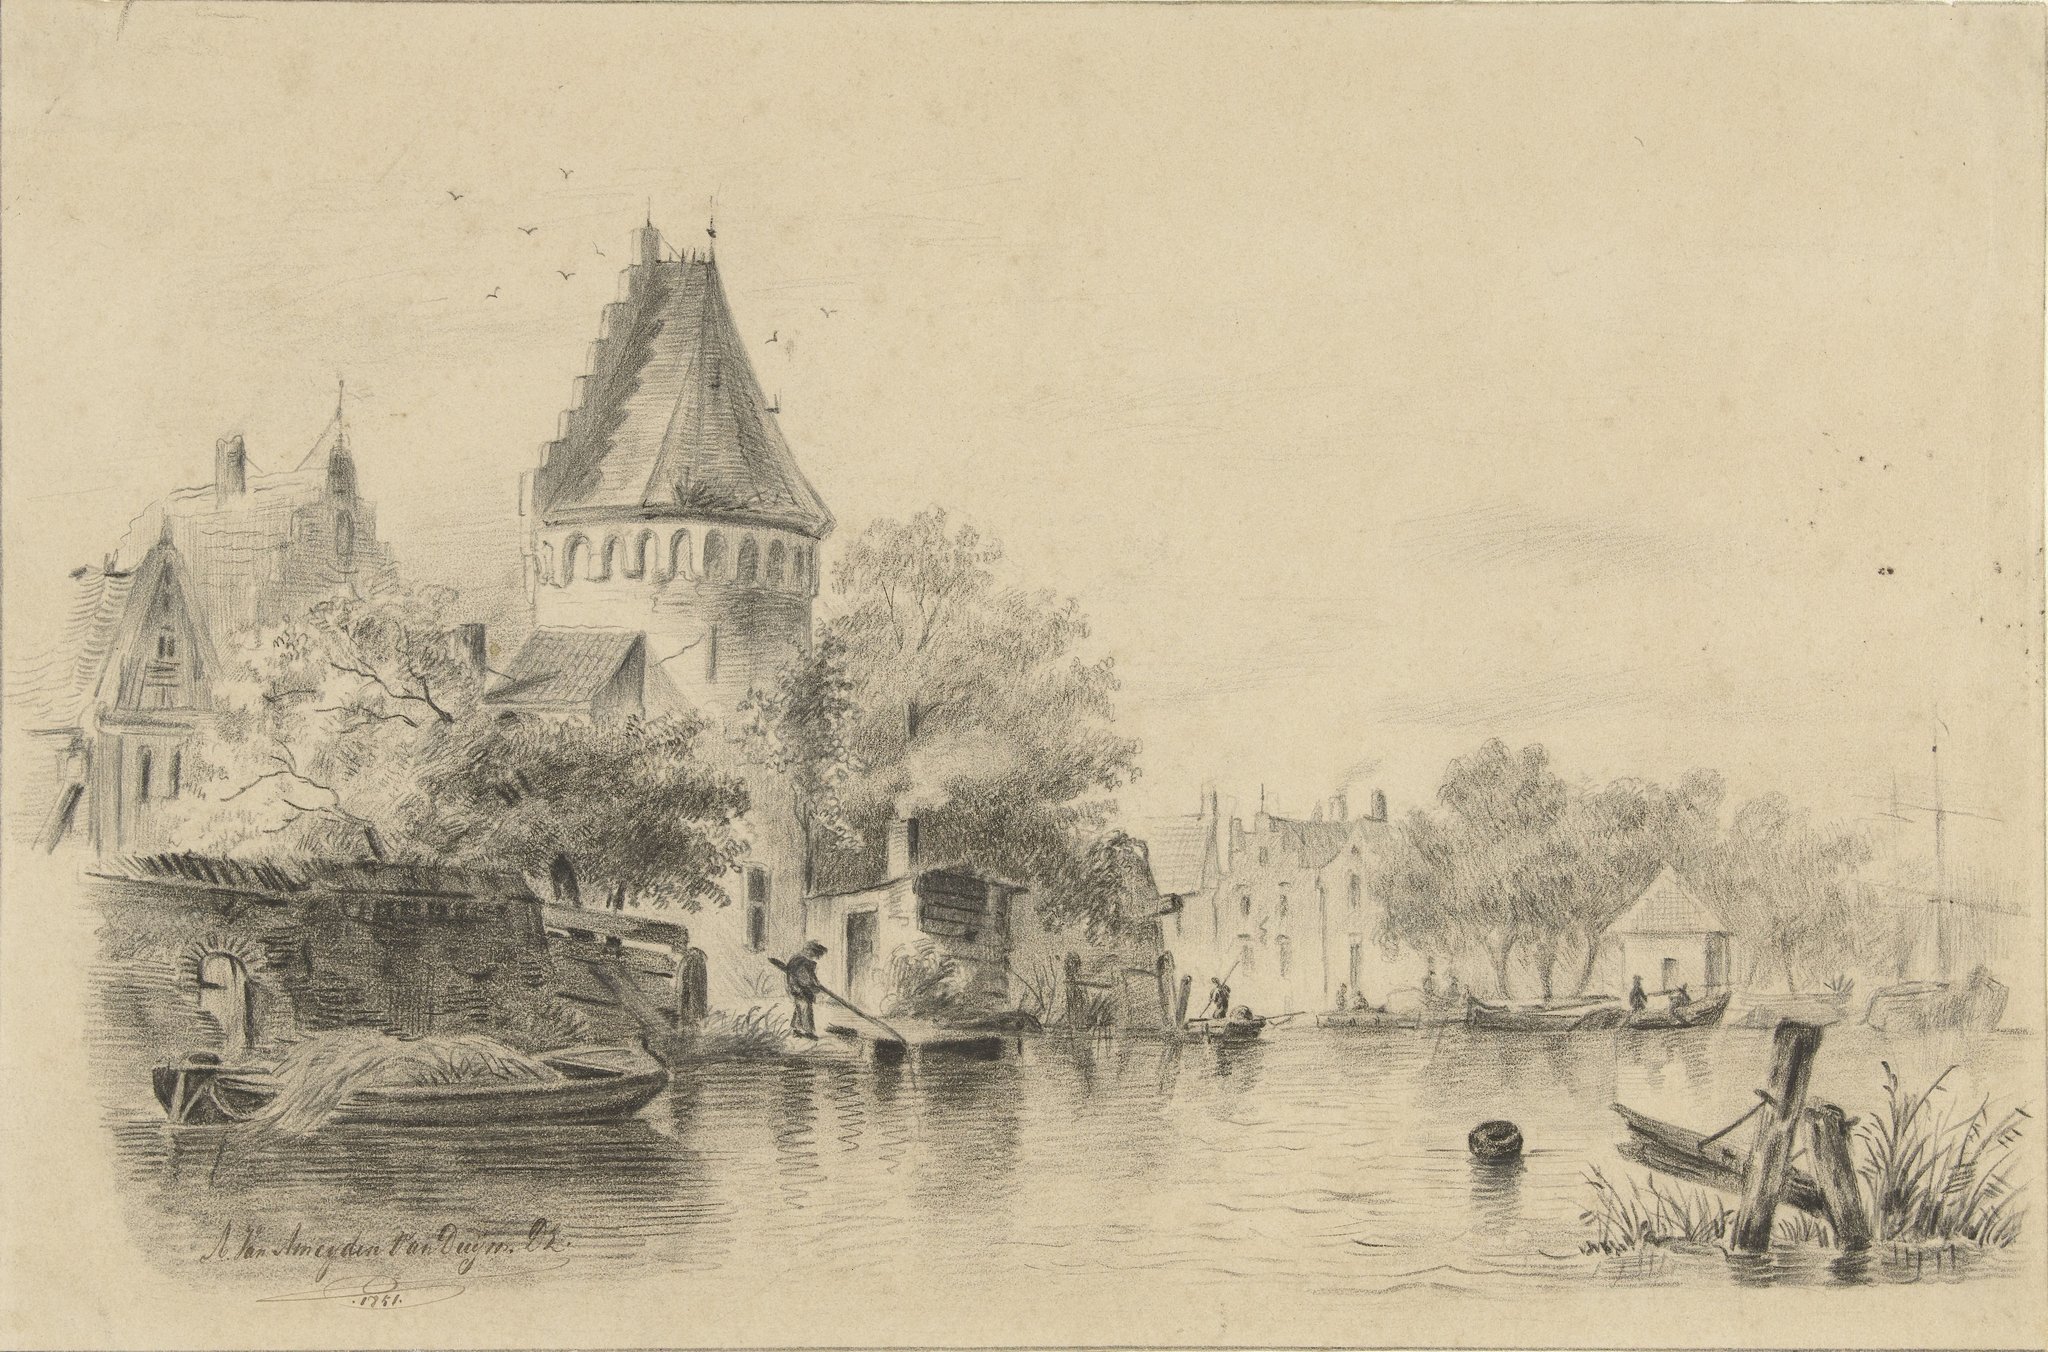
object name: drawing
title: Landschap met een toren aan het water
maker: a. van ameyden van duyn dzn.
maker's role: draughtsman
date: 1851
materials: chalk, paper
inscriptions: date: ‘1851’